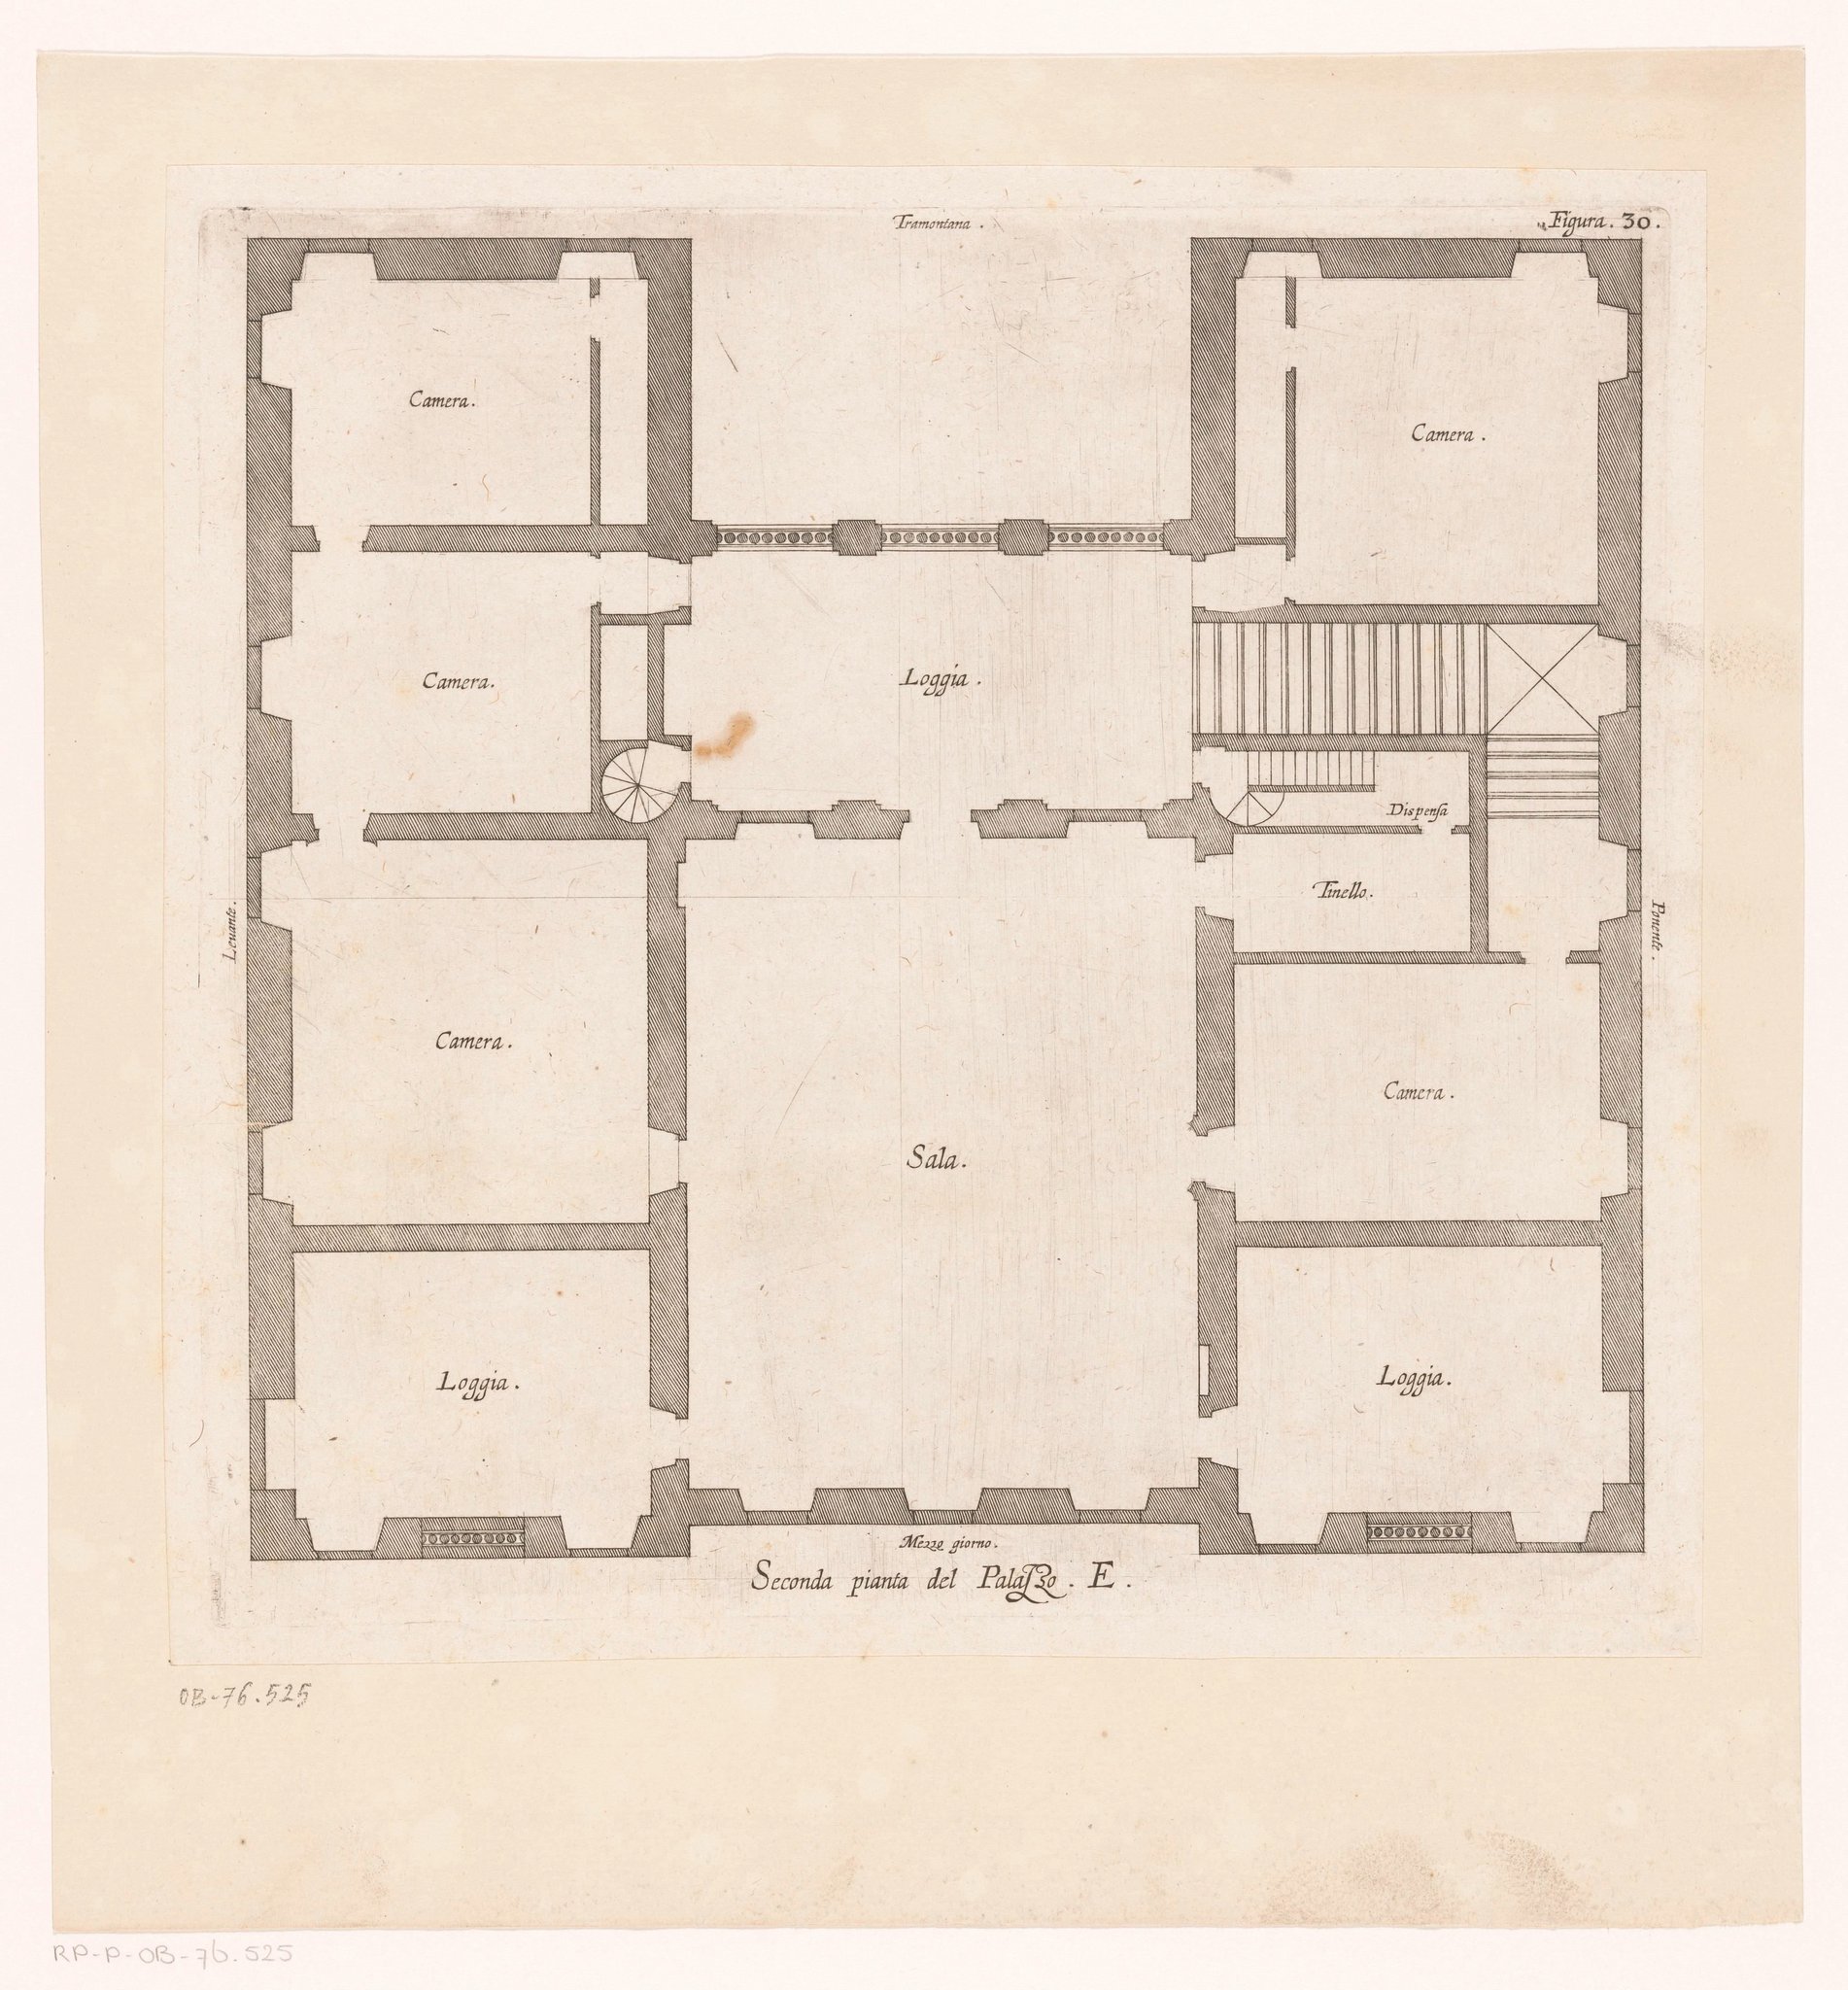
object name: ornament print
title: Seconda pianta del Palazzo. E.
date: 1622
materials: paper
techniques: engraving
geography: antwerp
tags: hôtel, i.e. small palace in city - aa - civic architecture: inside, plan ~ architecture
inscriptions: collector's mark: Lugt 240